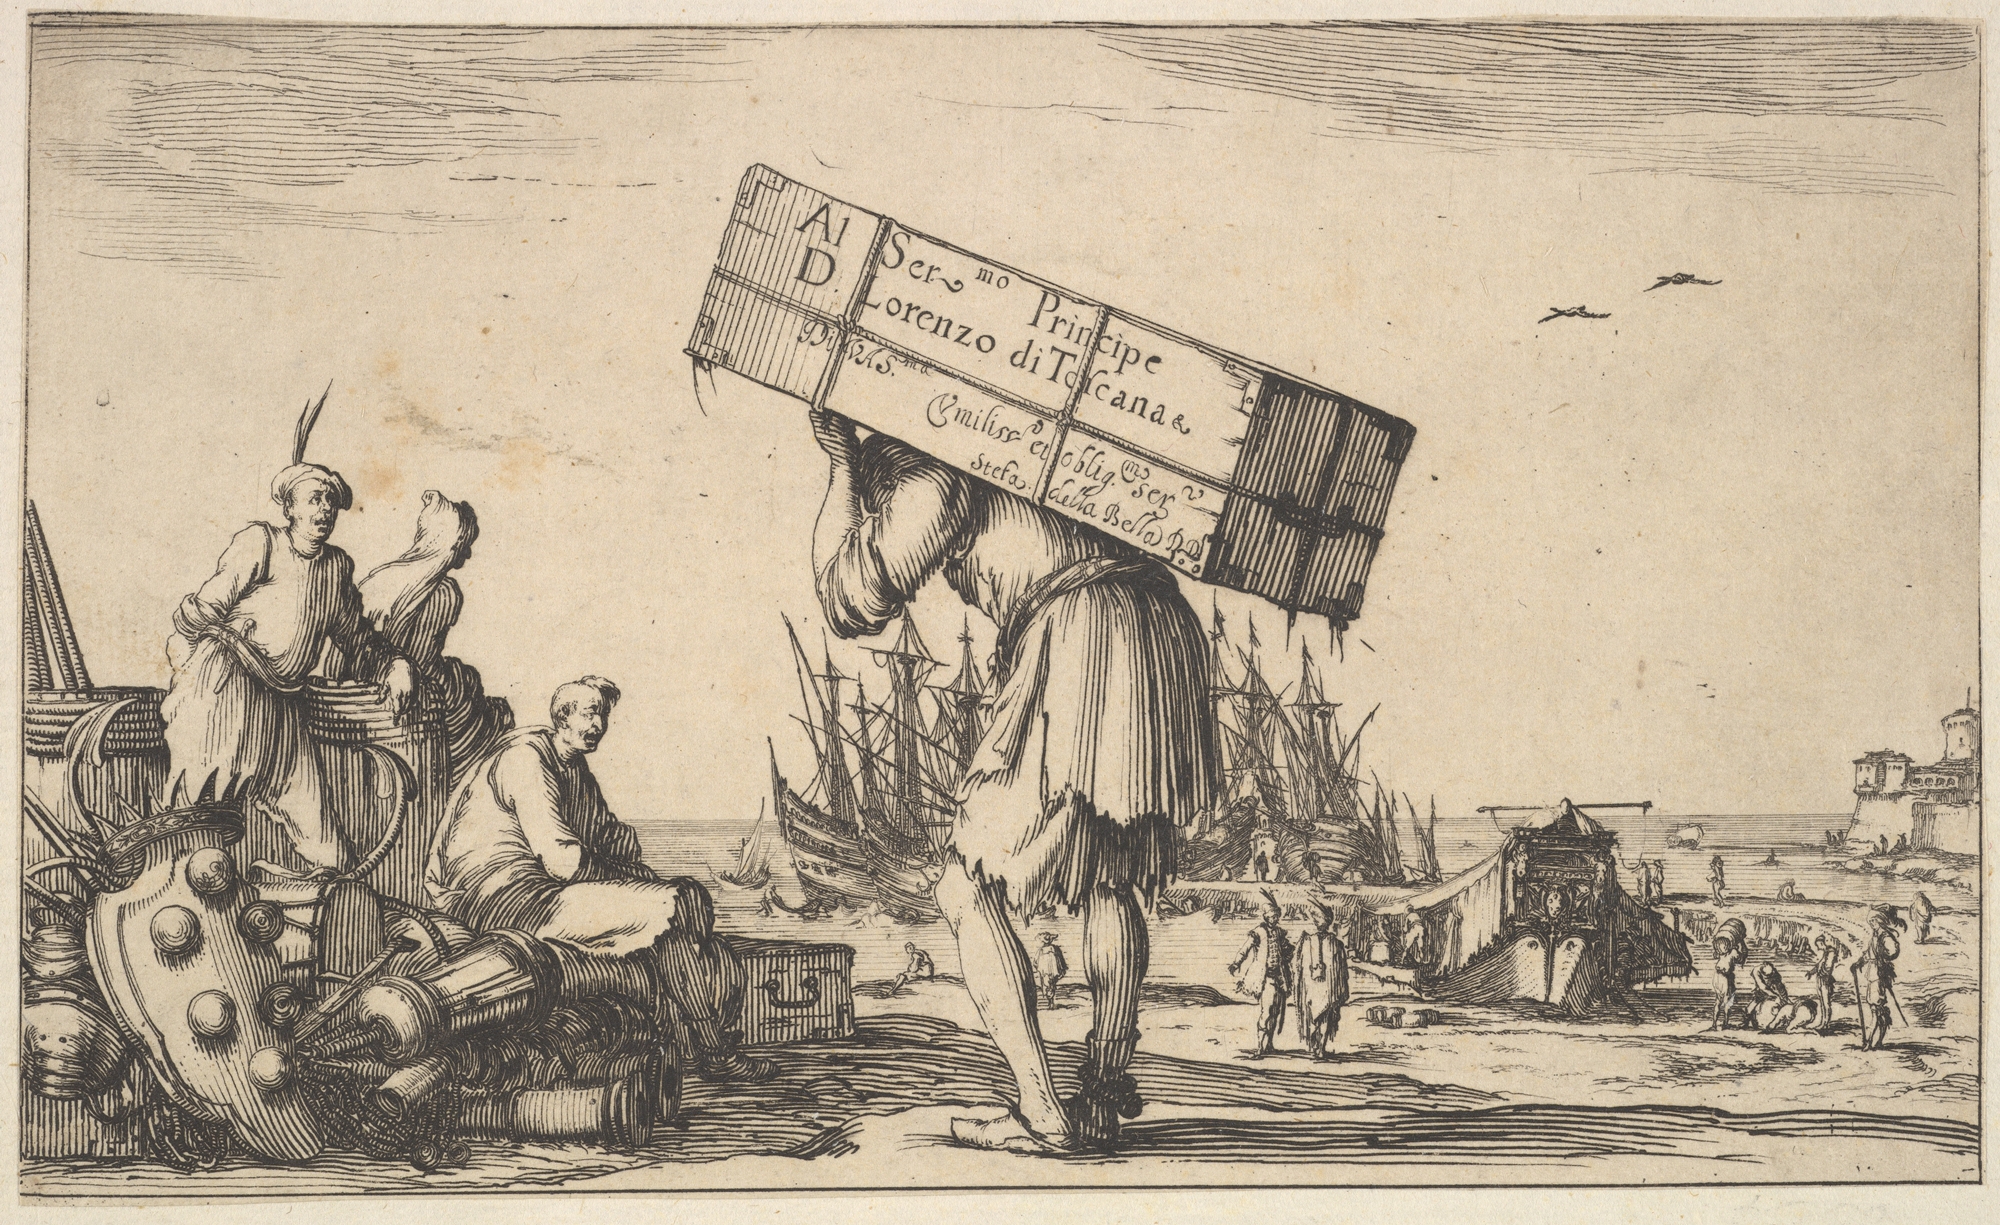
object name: print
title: Title page: a man carrying a case on his back in center, three men looking towards him on left, Medici coat of arms on ground to left, various boats and figures to right in the background, from "Set of eight nautical landscapes" (Suite de huit Marines)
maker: stefano della bella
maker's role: artist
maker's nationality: italian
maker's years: 1610-1664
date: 1639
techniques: etching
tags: men,working,coat of arms,boats